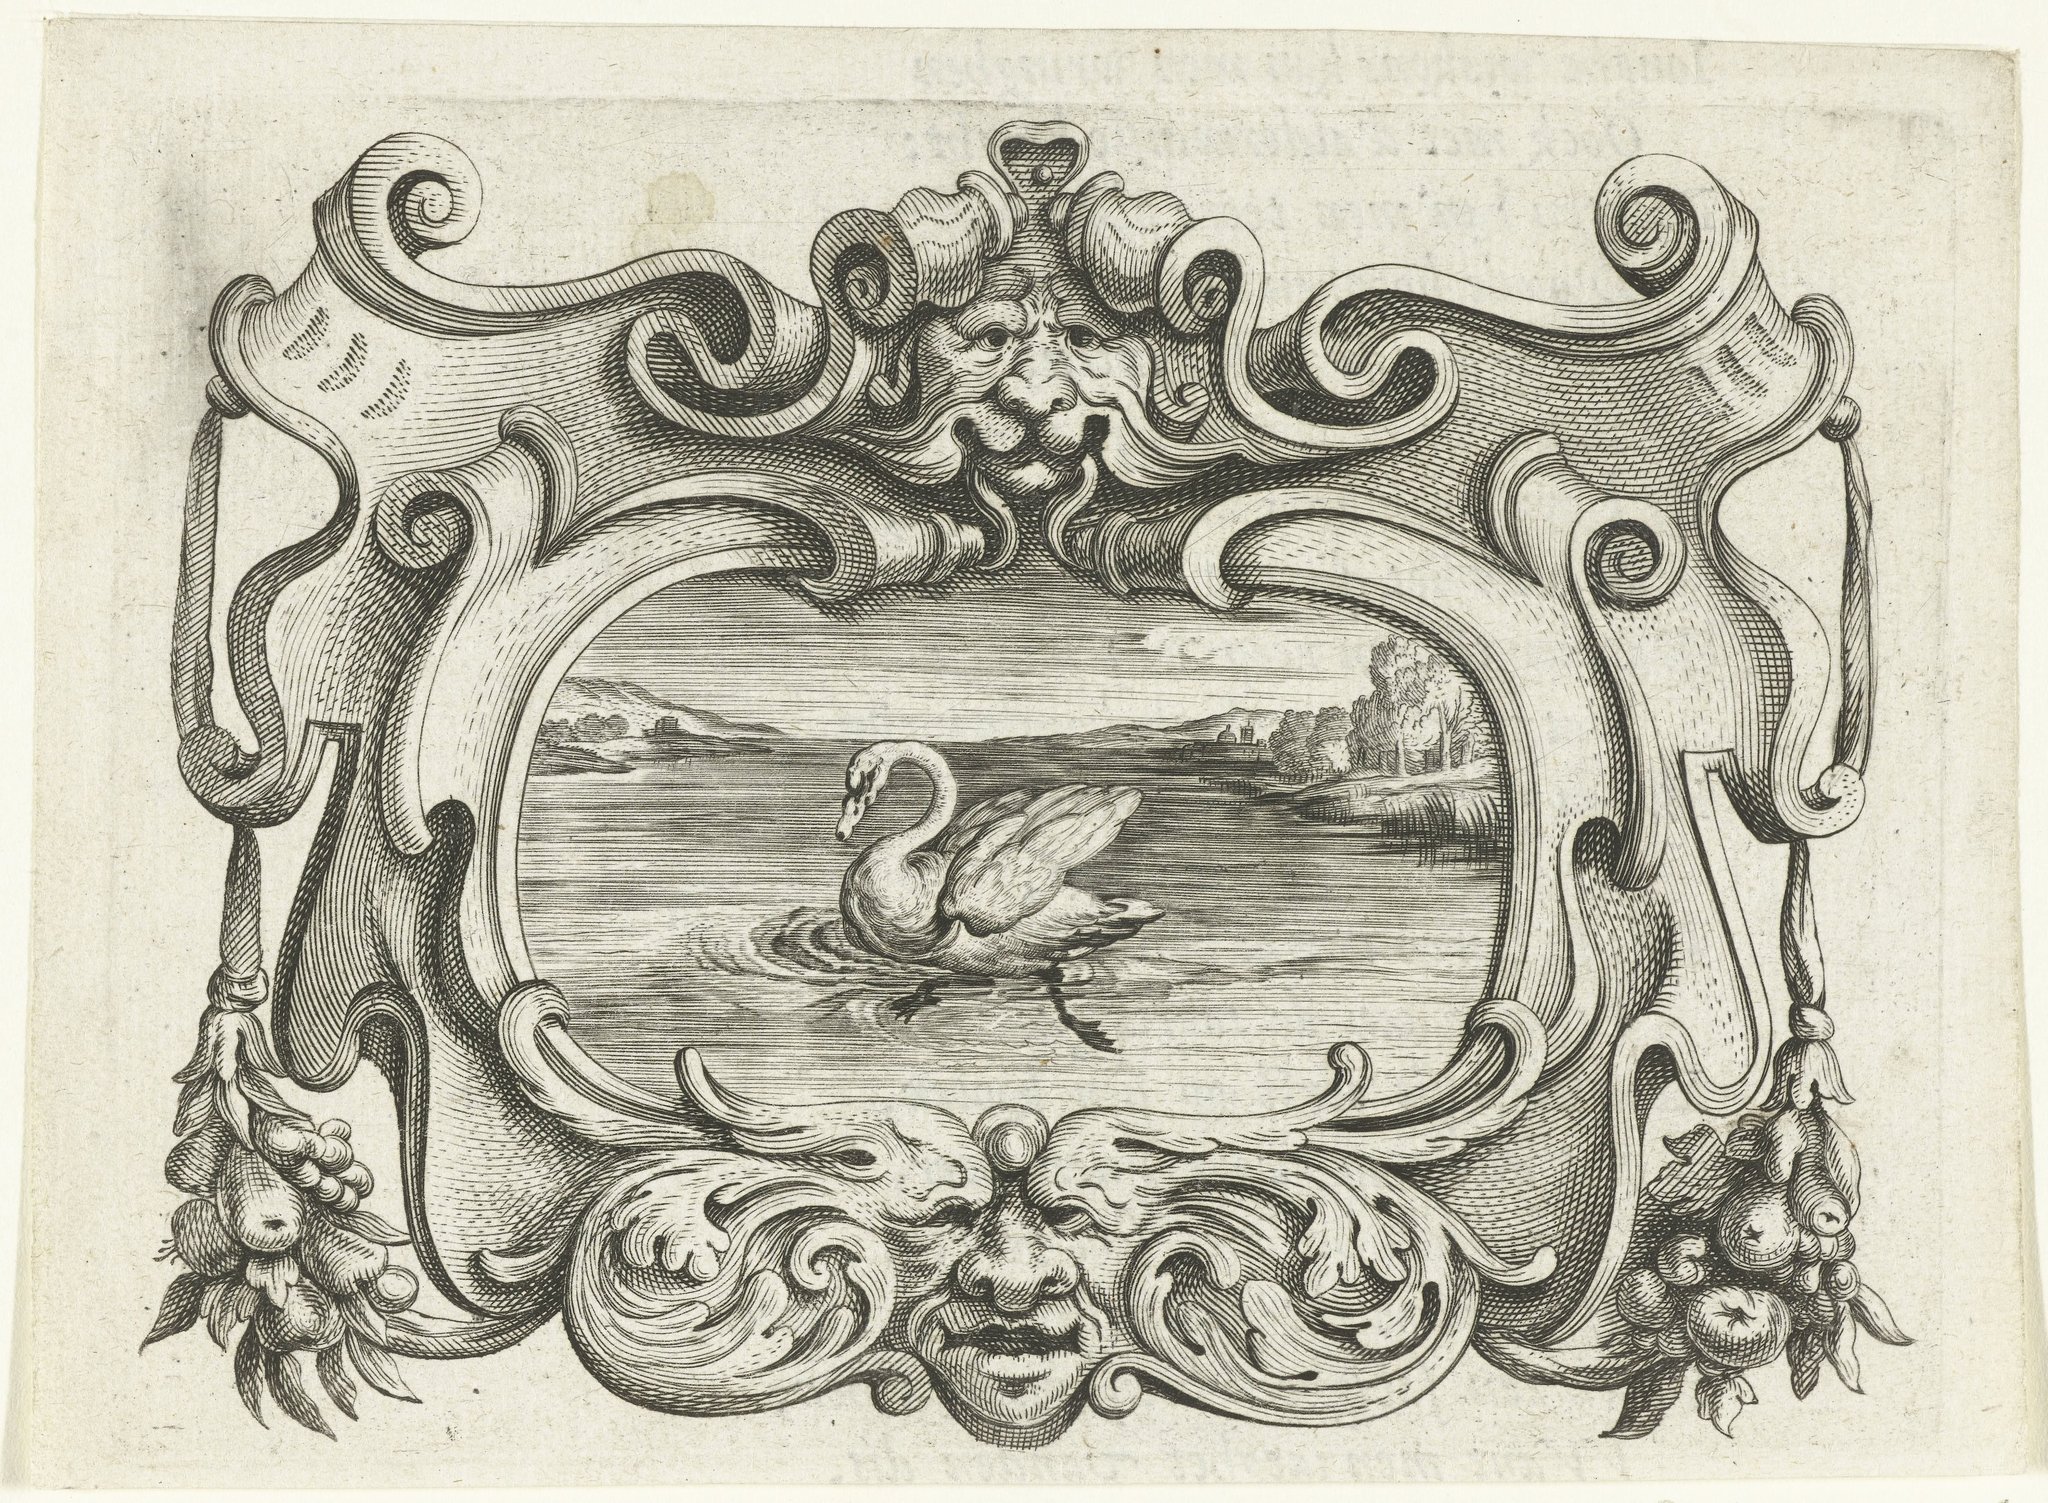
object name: print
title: Afbeeldinghe van d'eerste eeuwe der Societeit Iesv voor ooghen ghestelt door de Duyts-Nederlantsche Provincie der selver Societeyt.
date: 1640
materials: paper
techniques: engraving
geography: antwerp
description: Uit serie van 38 cartouches, gedecoreerd met maskers, guirlandes van fruit en bloemen, schelpen en dieren.